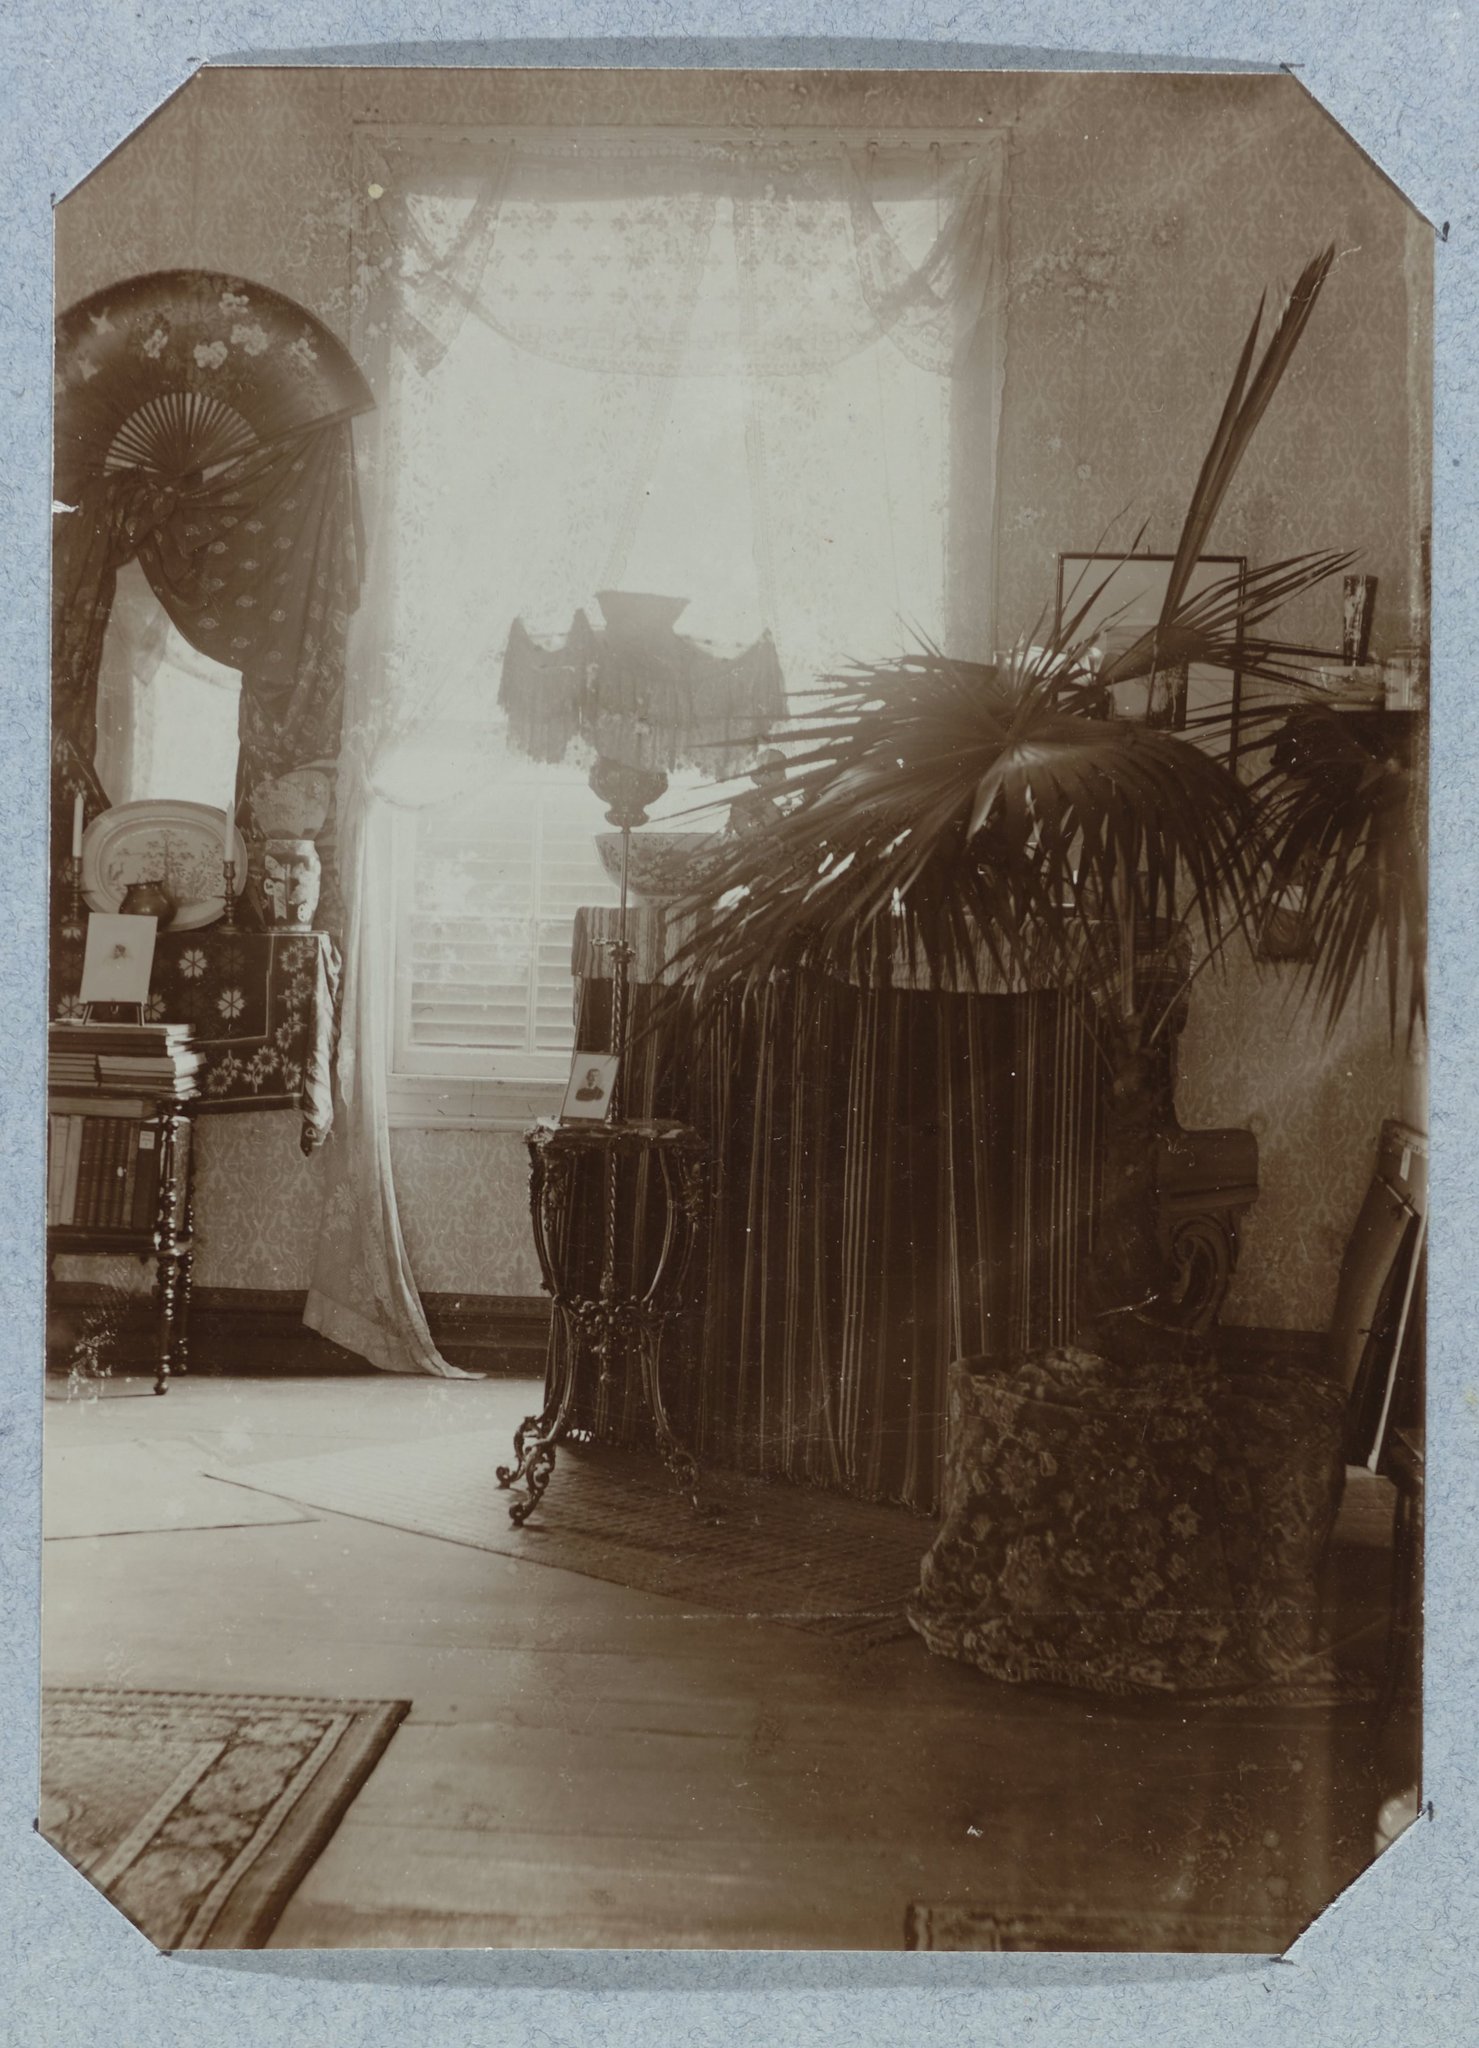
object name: photograph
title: Ons Intérieur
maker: théodore van lelyveld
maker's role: painter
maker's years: 1867-1954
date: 1895-1896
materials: photographic support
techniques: collodion silver print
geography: suriname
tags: communal rooms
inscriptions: inscription: ‘Ons Intérieur’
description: Interieur van het huis van het echtpaar Lelyveld aan de Gravenstraat te Paramaribo. Fotoafdruk in een fotoalbum van Théodore van Lelyveld over Suriname uit 1895-1898.